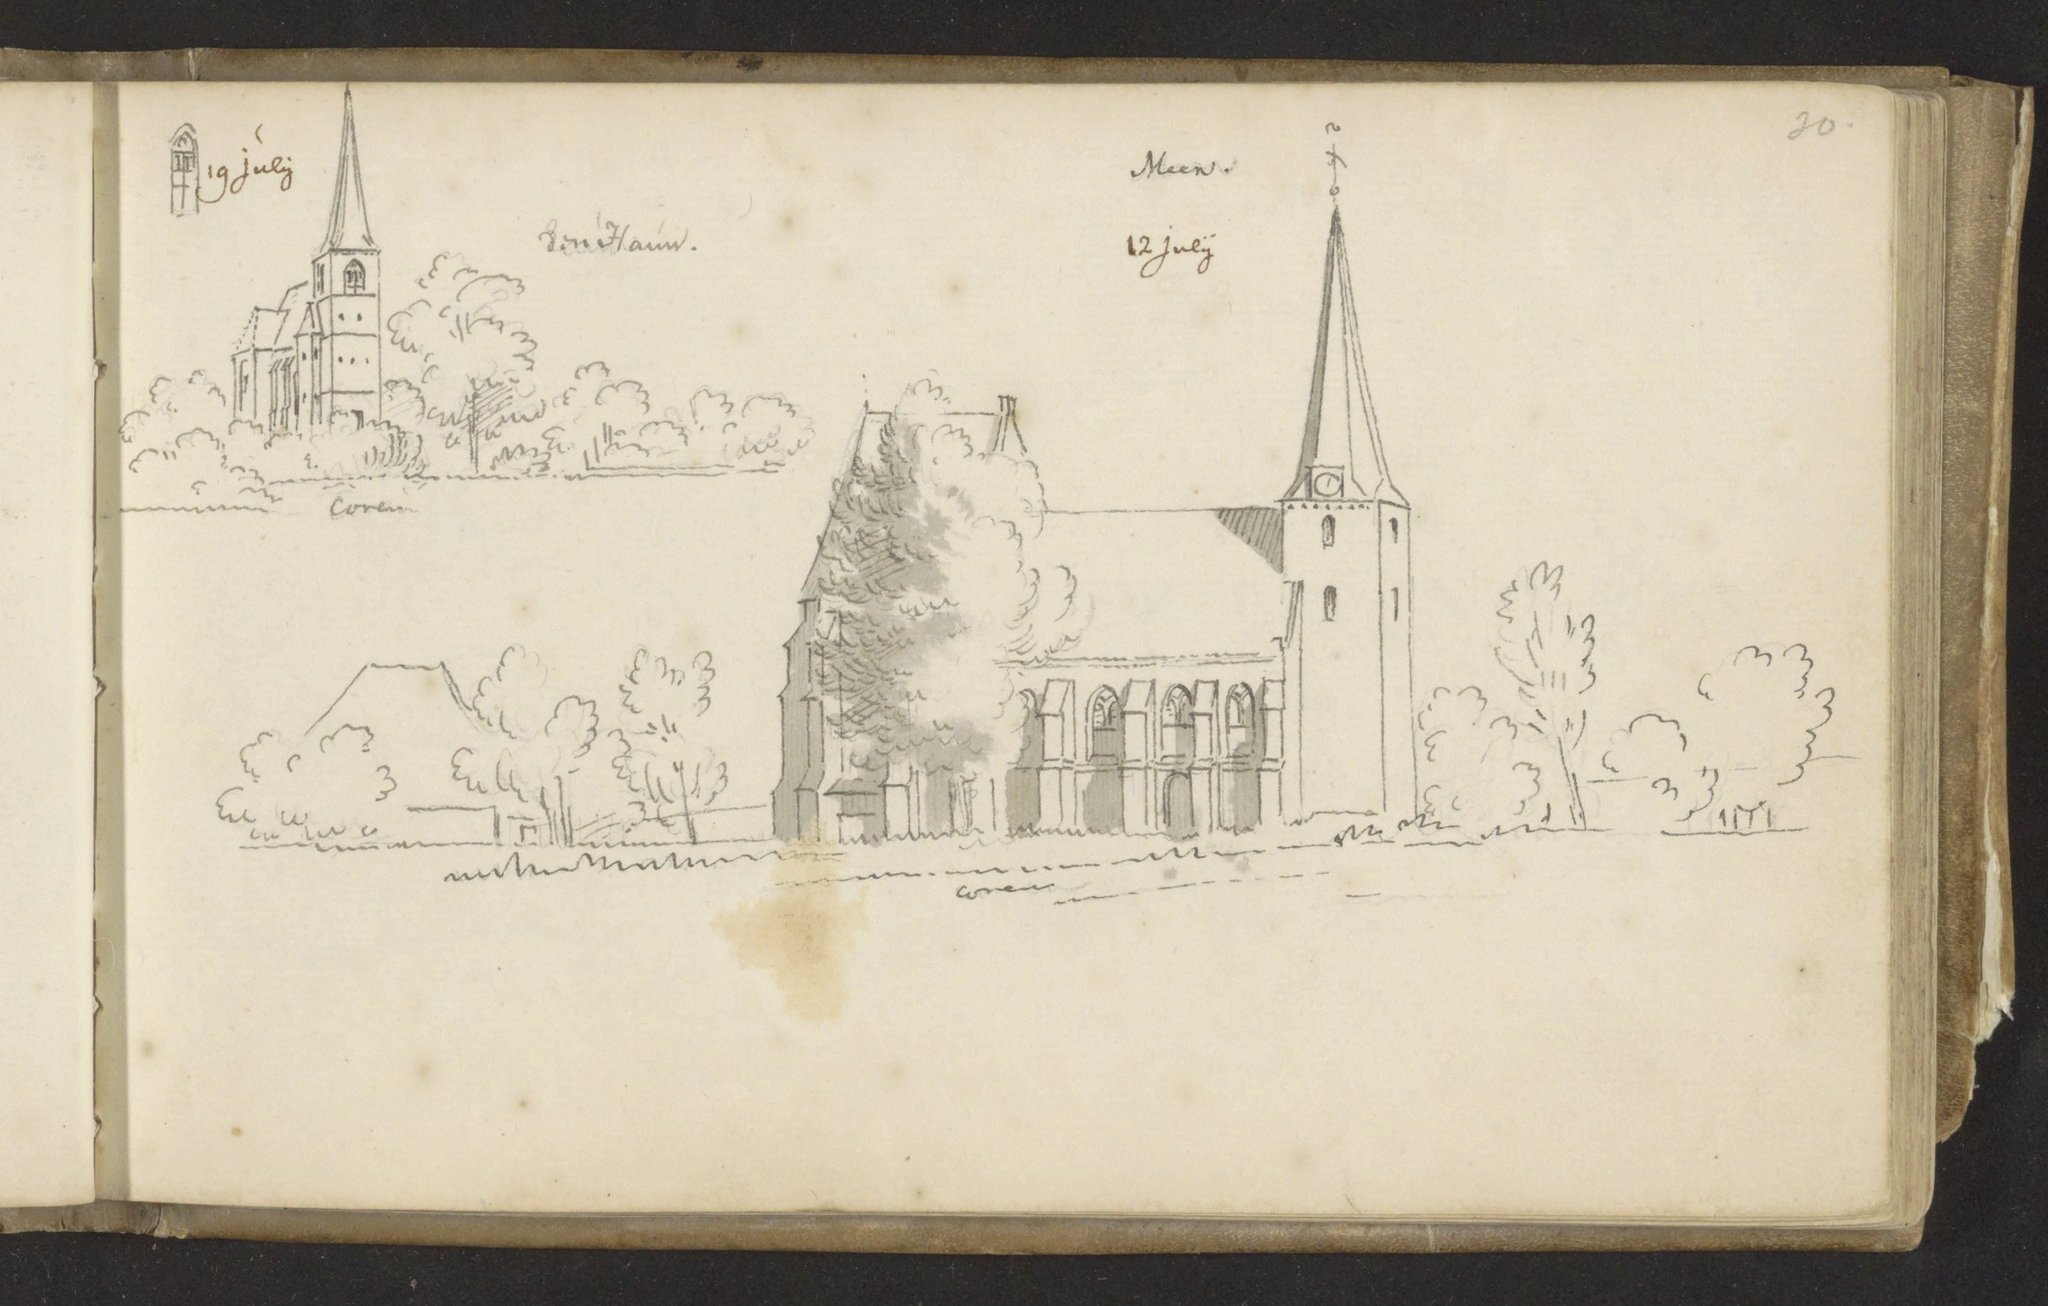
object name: sketchbook leaf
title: Dorpsgezichten met kerk te Mehr en Den Ham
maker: abraham de haen (ii)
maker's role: draughtsman, print maker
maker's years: 1707-1748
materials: ink, paper, pencil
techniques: brush, pen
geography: den ham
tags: prospect of village, silhouette of village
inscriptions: date and inscription: ‘19 julij/ den Ham./ Mehr/ 12 Julij’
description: Blad 30 recto uit een schetsboek met 69 bladen.